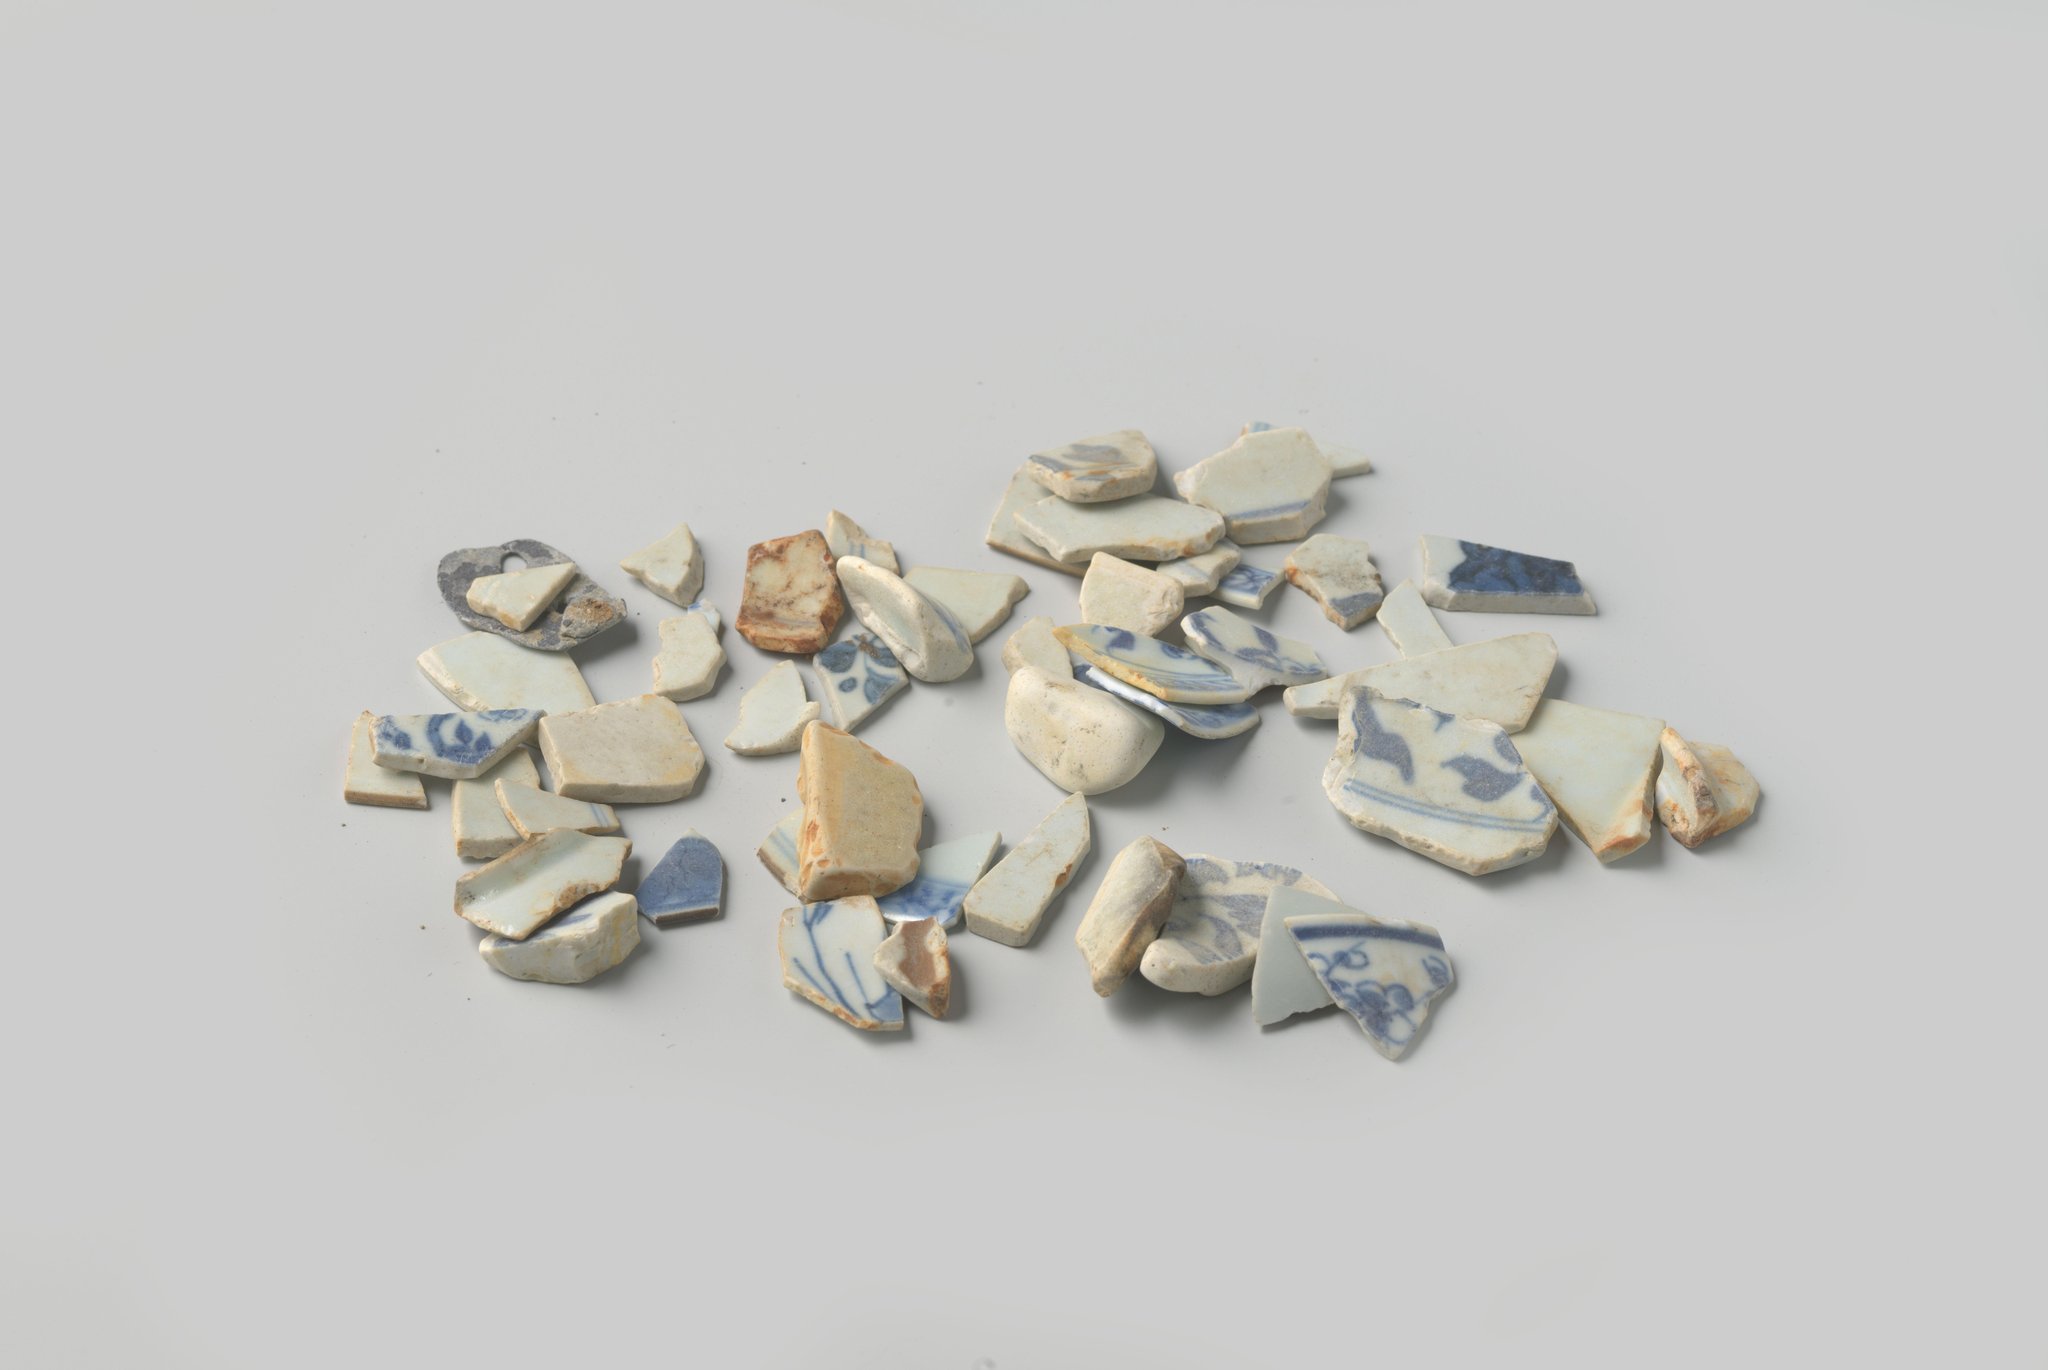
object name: sherd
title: Scherven porselein, tinfragment en kei uit het wrak van de Oostindiëvaarder Hollandia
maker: Anonymous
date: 1700-1743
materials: porcelain, tin